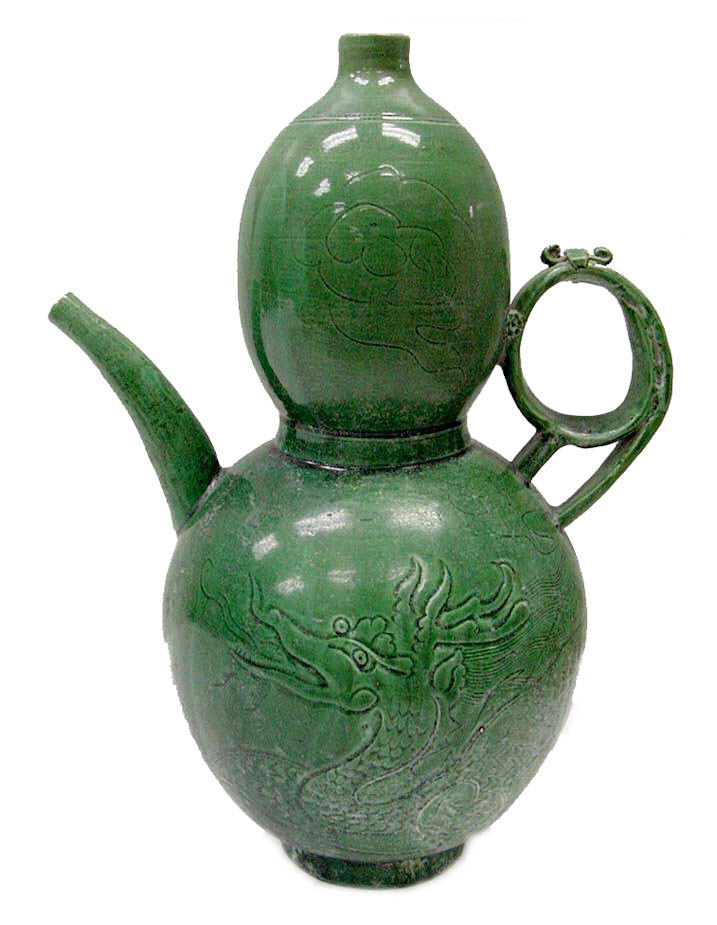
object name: ewer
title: Ewer with writhing dragon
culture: chinese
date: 901-1100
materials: pottery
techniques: glazing, incising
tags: dragons